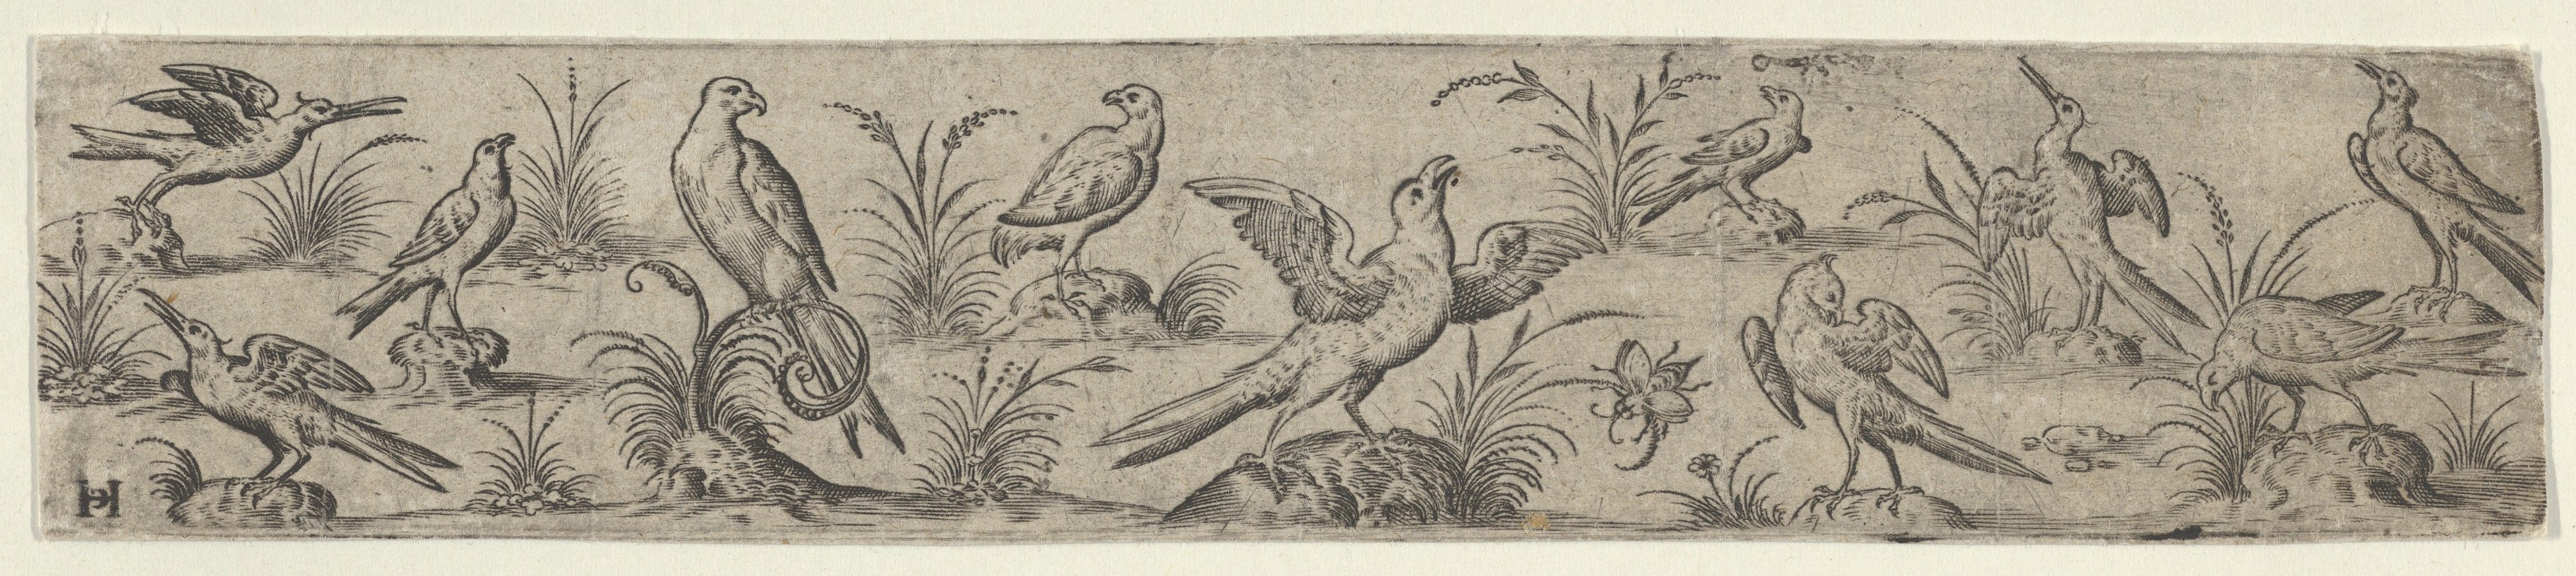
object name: print ornament architecture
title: Frieze with Eleven Birds and an Insect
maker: jan collaert i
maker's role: artist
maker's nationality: netherlandish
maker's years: 1530-1581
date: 1590-1612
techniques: engraving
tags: birds,insects